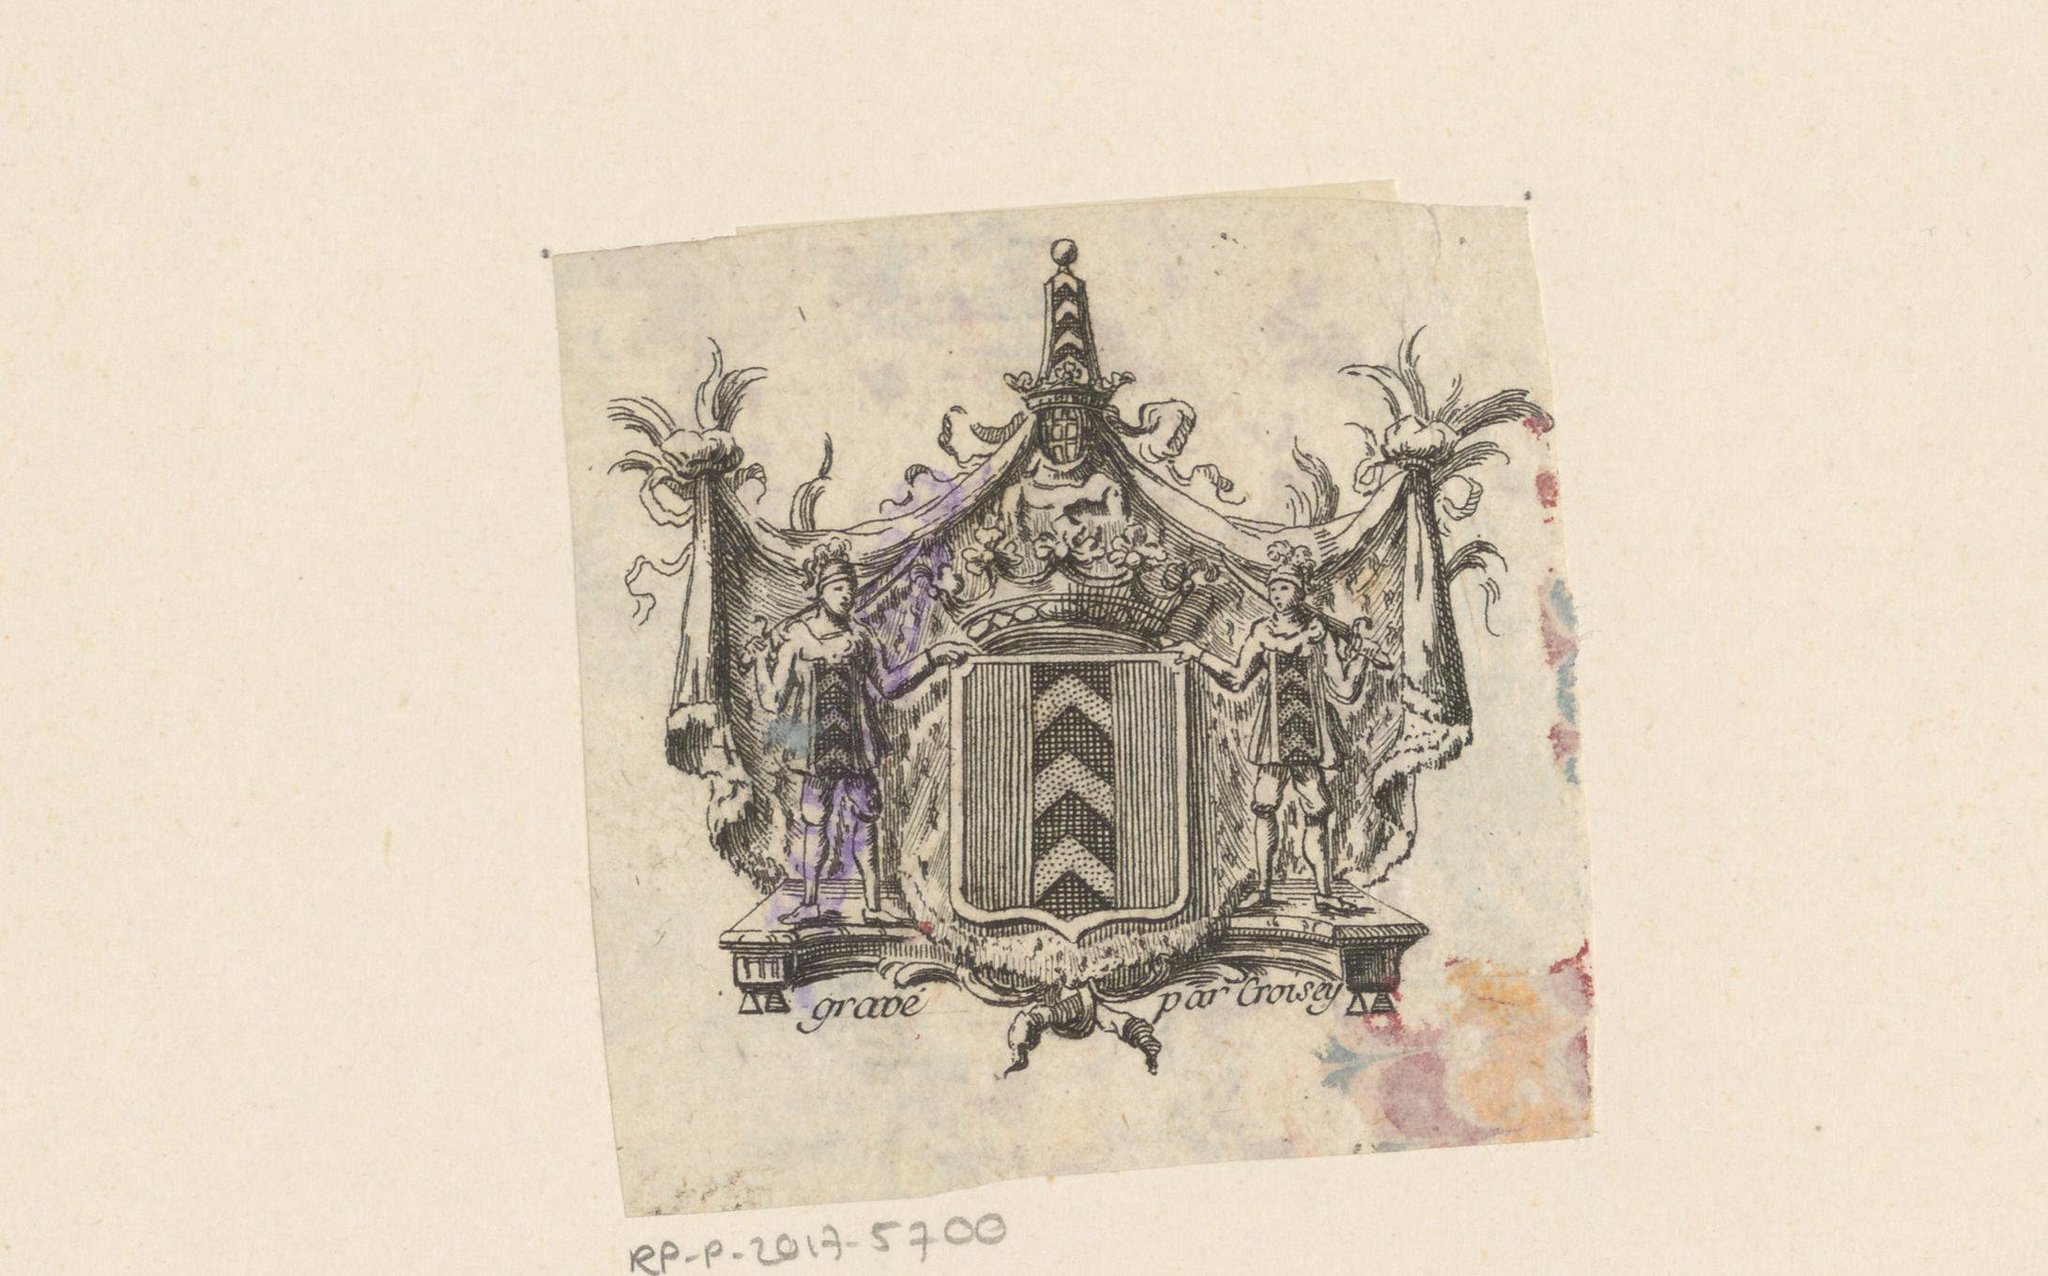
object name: bookplate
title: Ex libris van onbekend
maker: Anonymous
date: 1700-1799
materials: paper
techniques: etching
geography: france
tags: standing figure, armorial bearing, heraldry